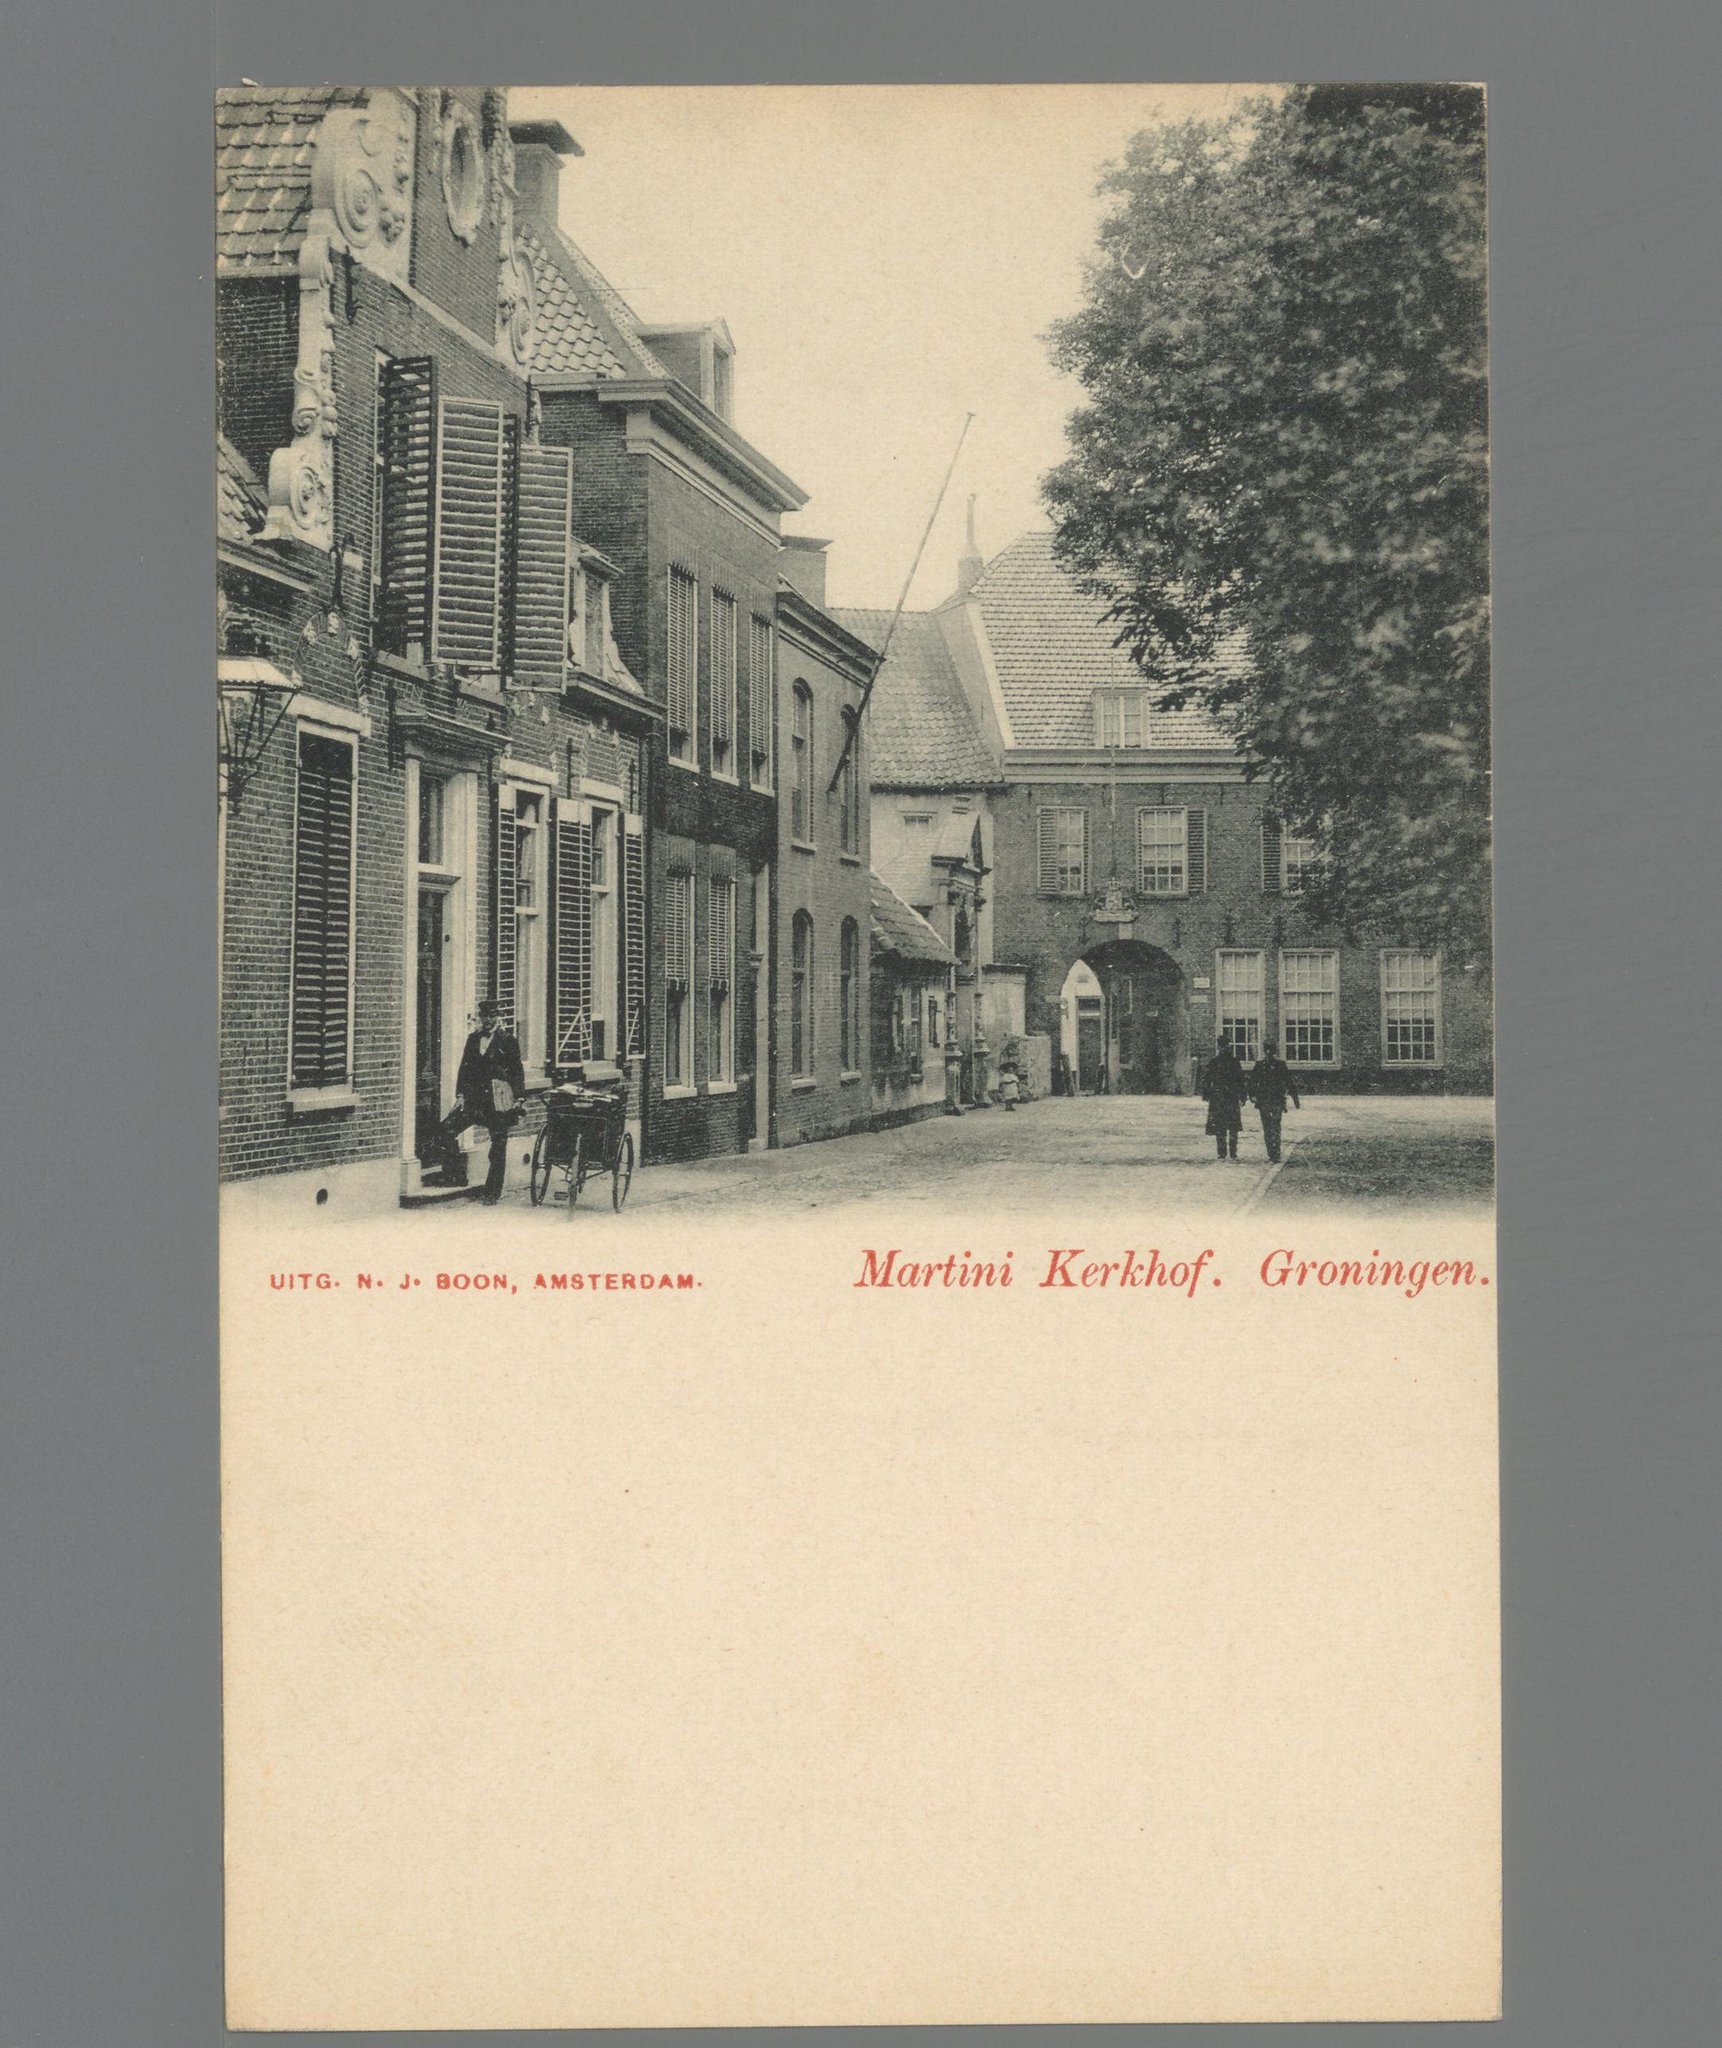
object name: photomechanical print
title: Martini Kerkhof. Groningen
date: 1897-1905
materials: cardboard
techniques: photograph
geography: groningen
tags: square, place, circus, etc.